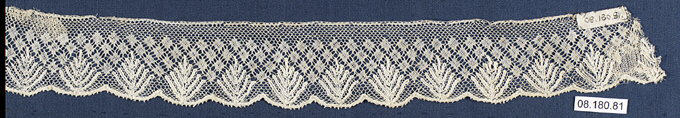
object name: fragment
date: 1801-1900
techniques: lace